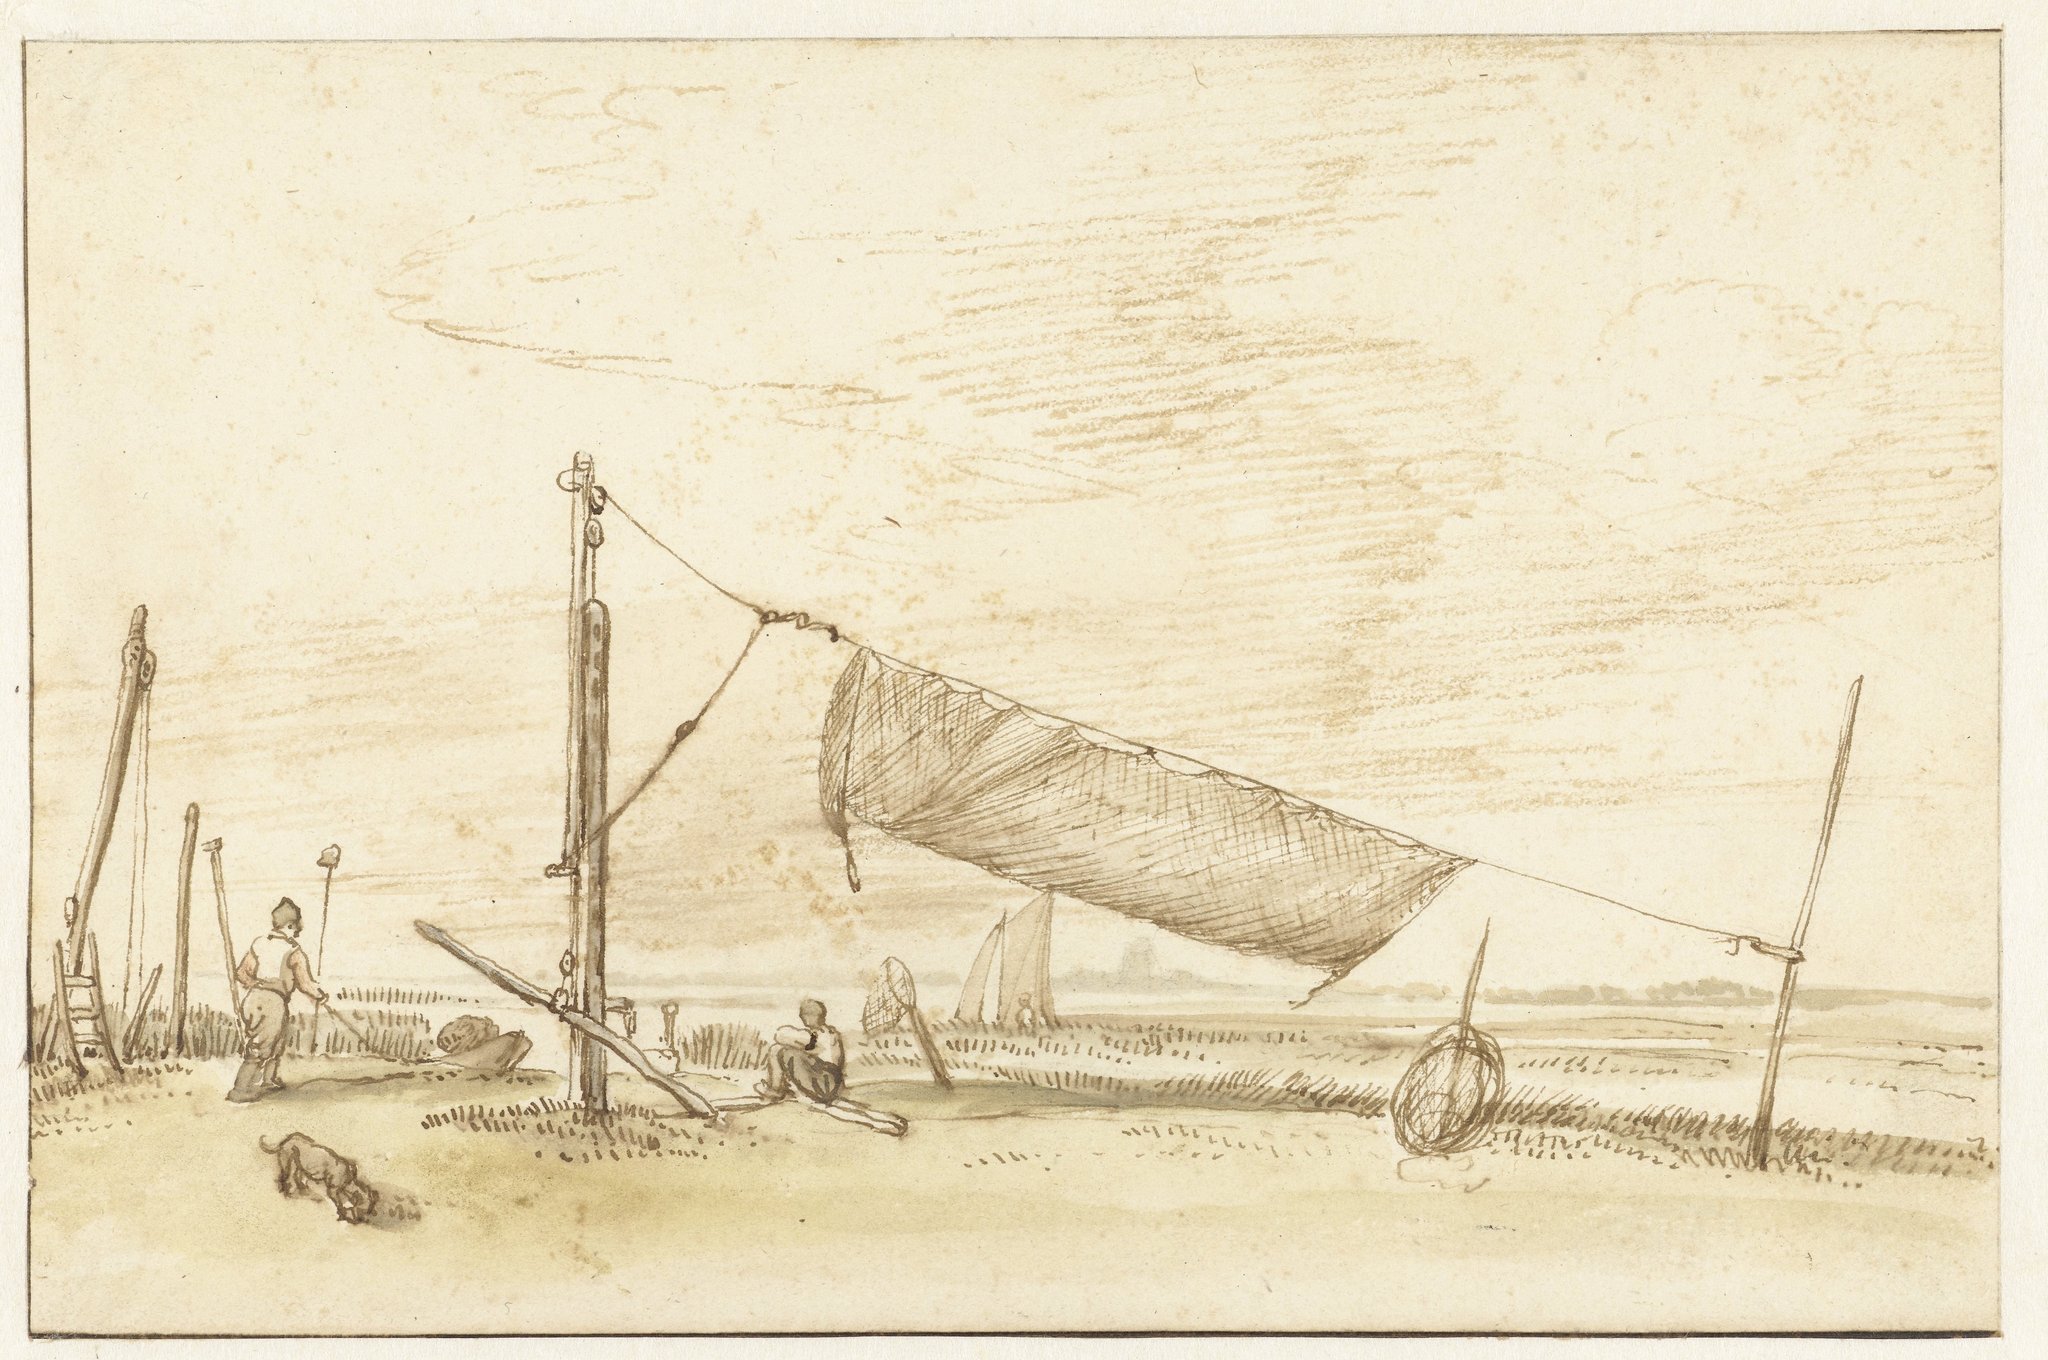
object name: drawing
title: Twee vissers aan de waterkant (het IJ?)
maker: anthonie van borssom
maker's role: draughtsman, print maker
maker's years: 1629-1677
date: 1640-1677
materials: ink, paper, watercolor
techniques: brush, pen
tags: fishing net, sea and coastal fishery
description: Op de voorgrond hangt een groot visnet te drogen. Op de achtergrond is zeer vaag een kerktoren te zien (Ransdorp?).